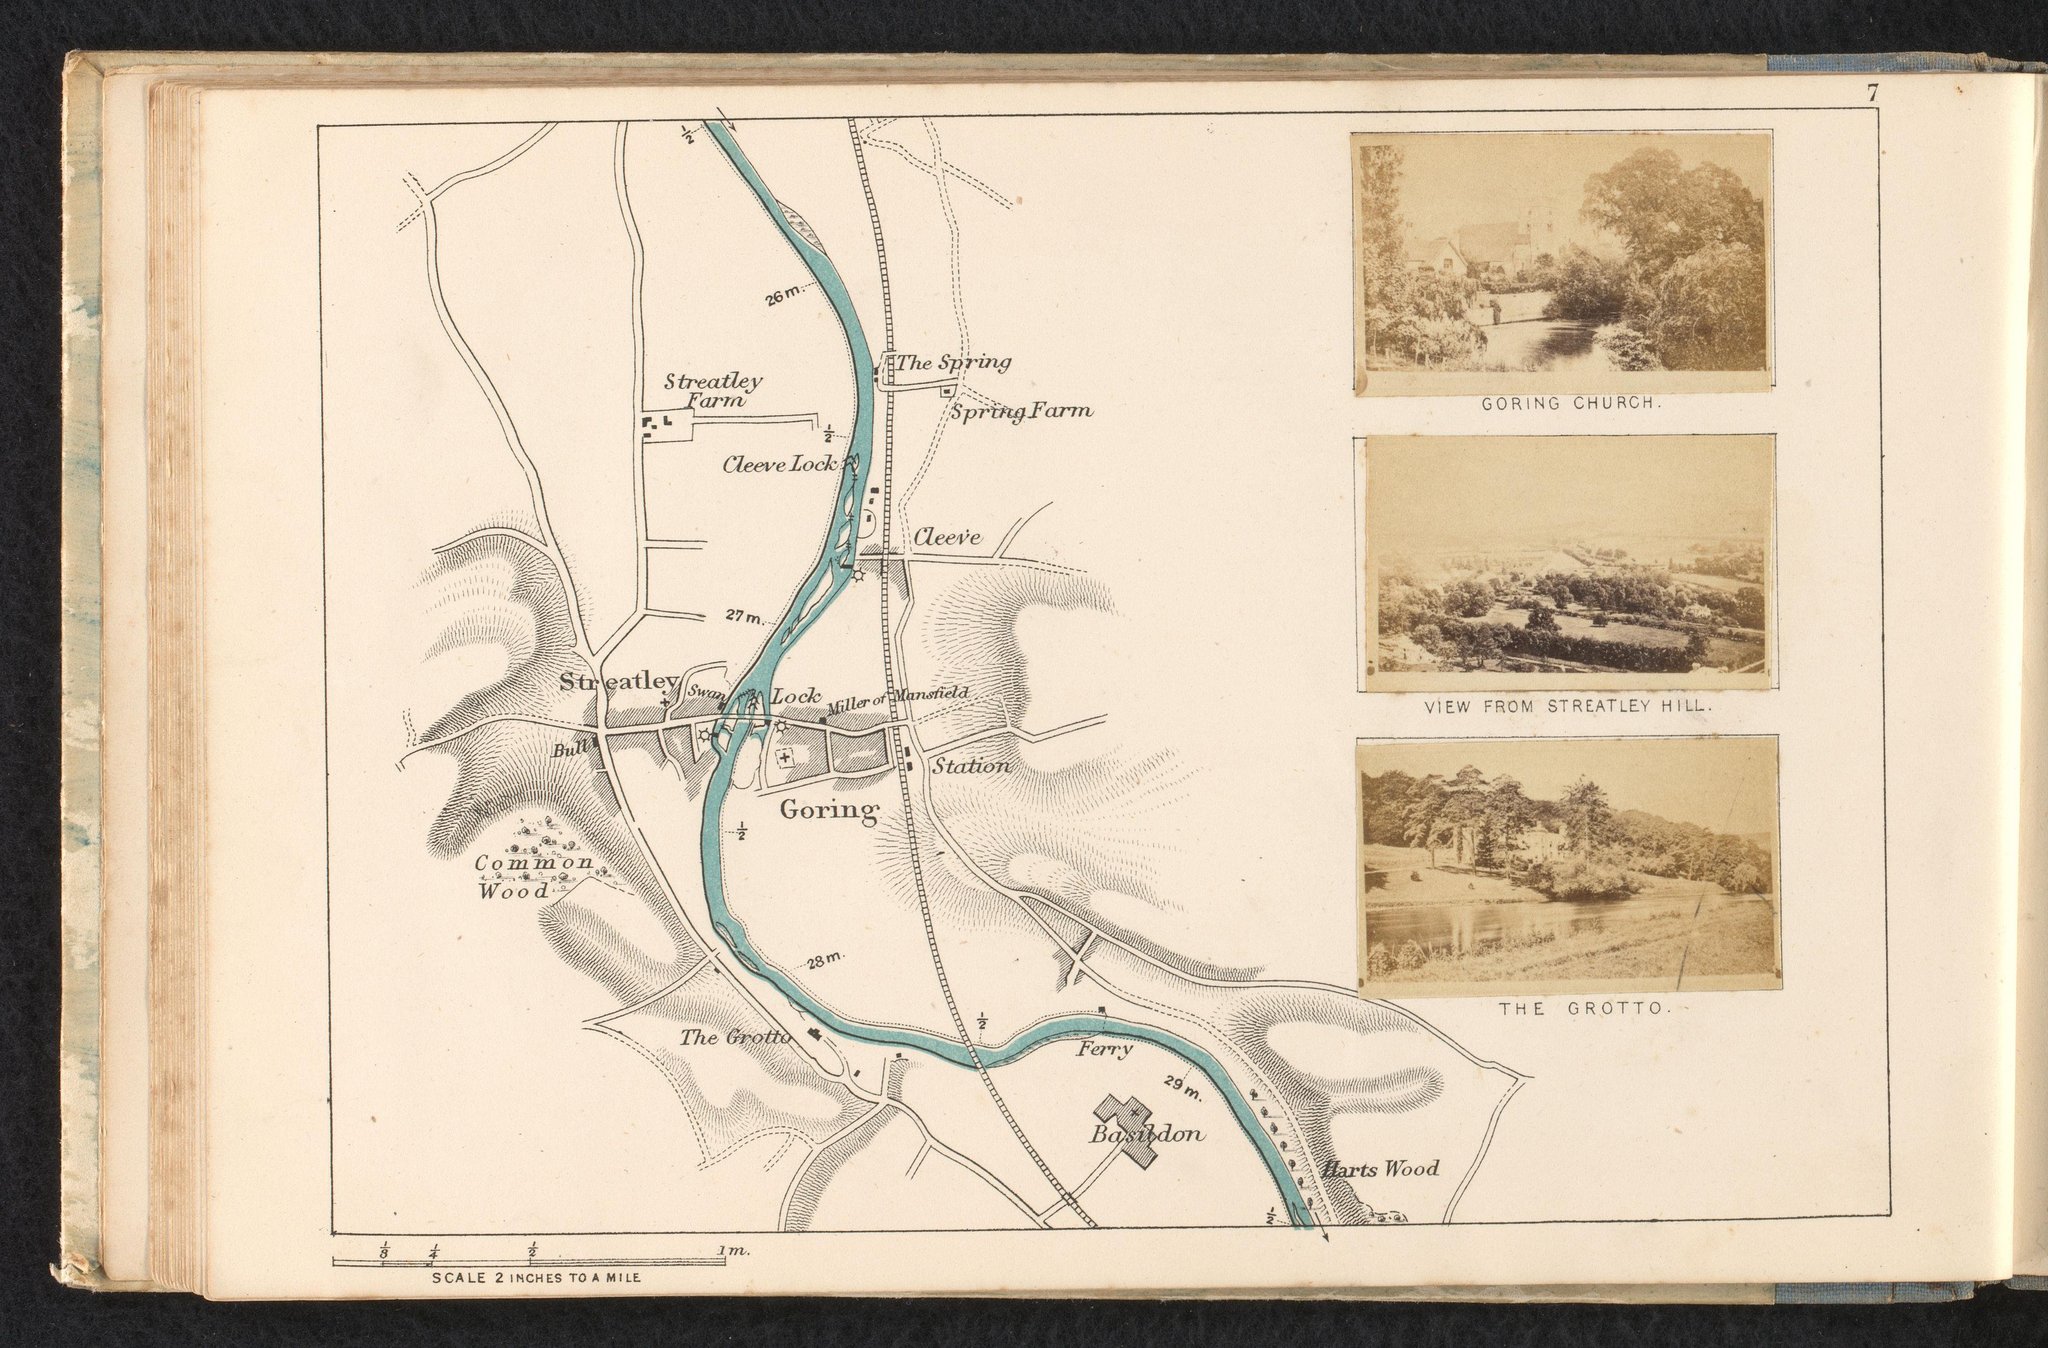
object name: photograph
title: Goring Church, View From Streatley Hill, The Grotto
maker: Anonymous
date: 1868-1873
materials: paper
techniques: albumen print, letterpress printing, line block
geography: england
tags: landscapes in the temperate zone, river bank, church (exterior), villa